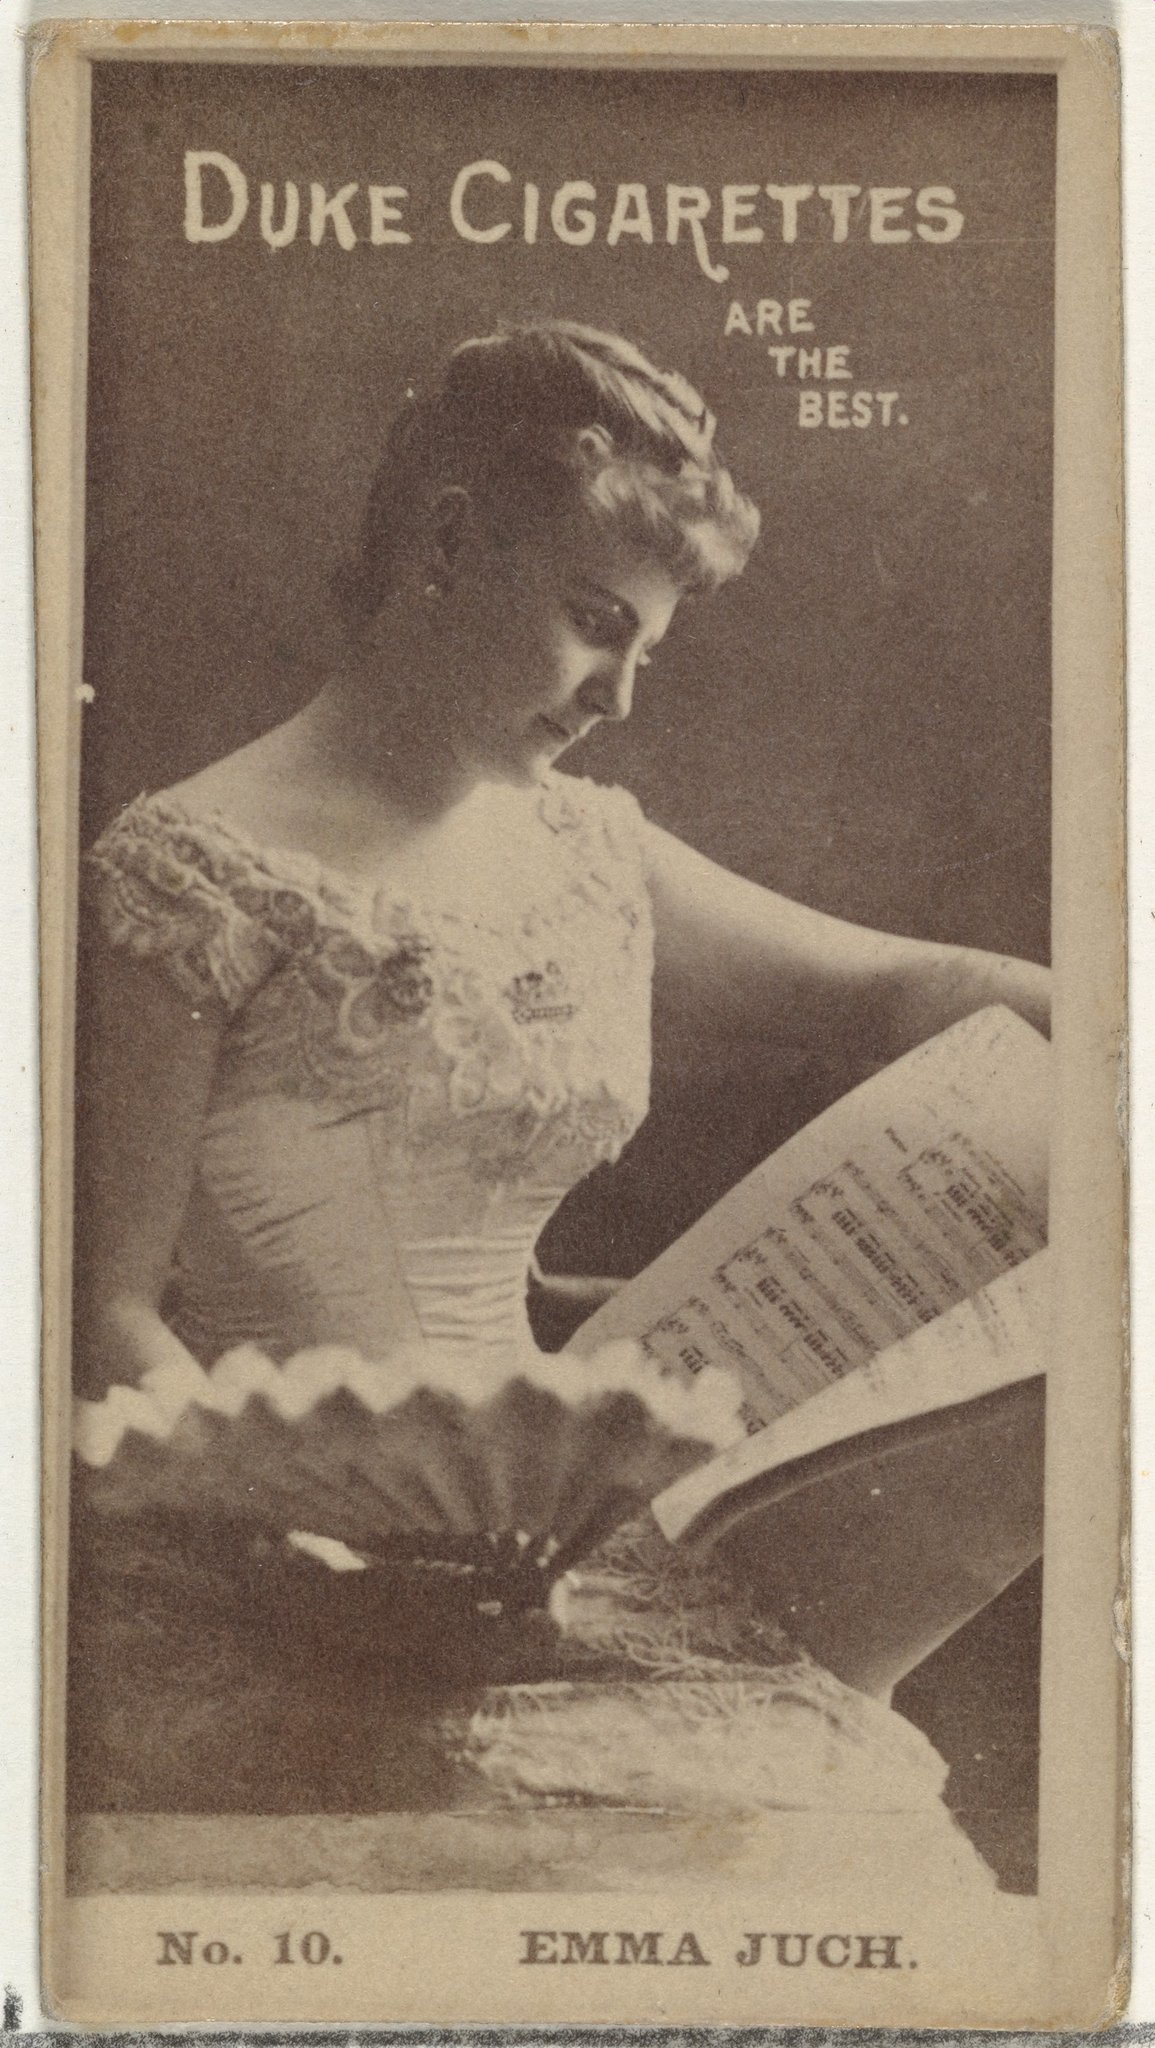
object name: photograph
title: Card Number 10, Emma Juch, from the Actors and Actresses series (N145-6) issued by Duke Sons & Co. to promote Duke Cigarettes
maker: w. duke, sons & co.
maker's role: publisher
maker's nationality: american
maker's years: 1870-1920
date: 1880-1889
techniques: albumen silver print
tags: women,reading,actresses